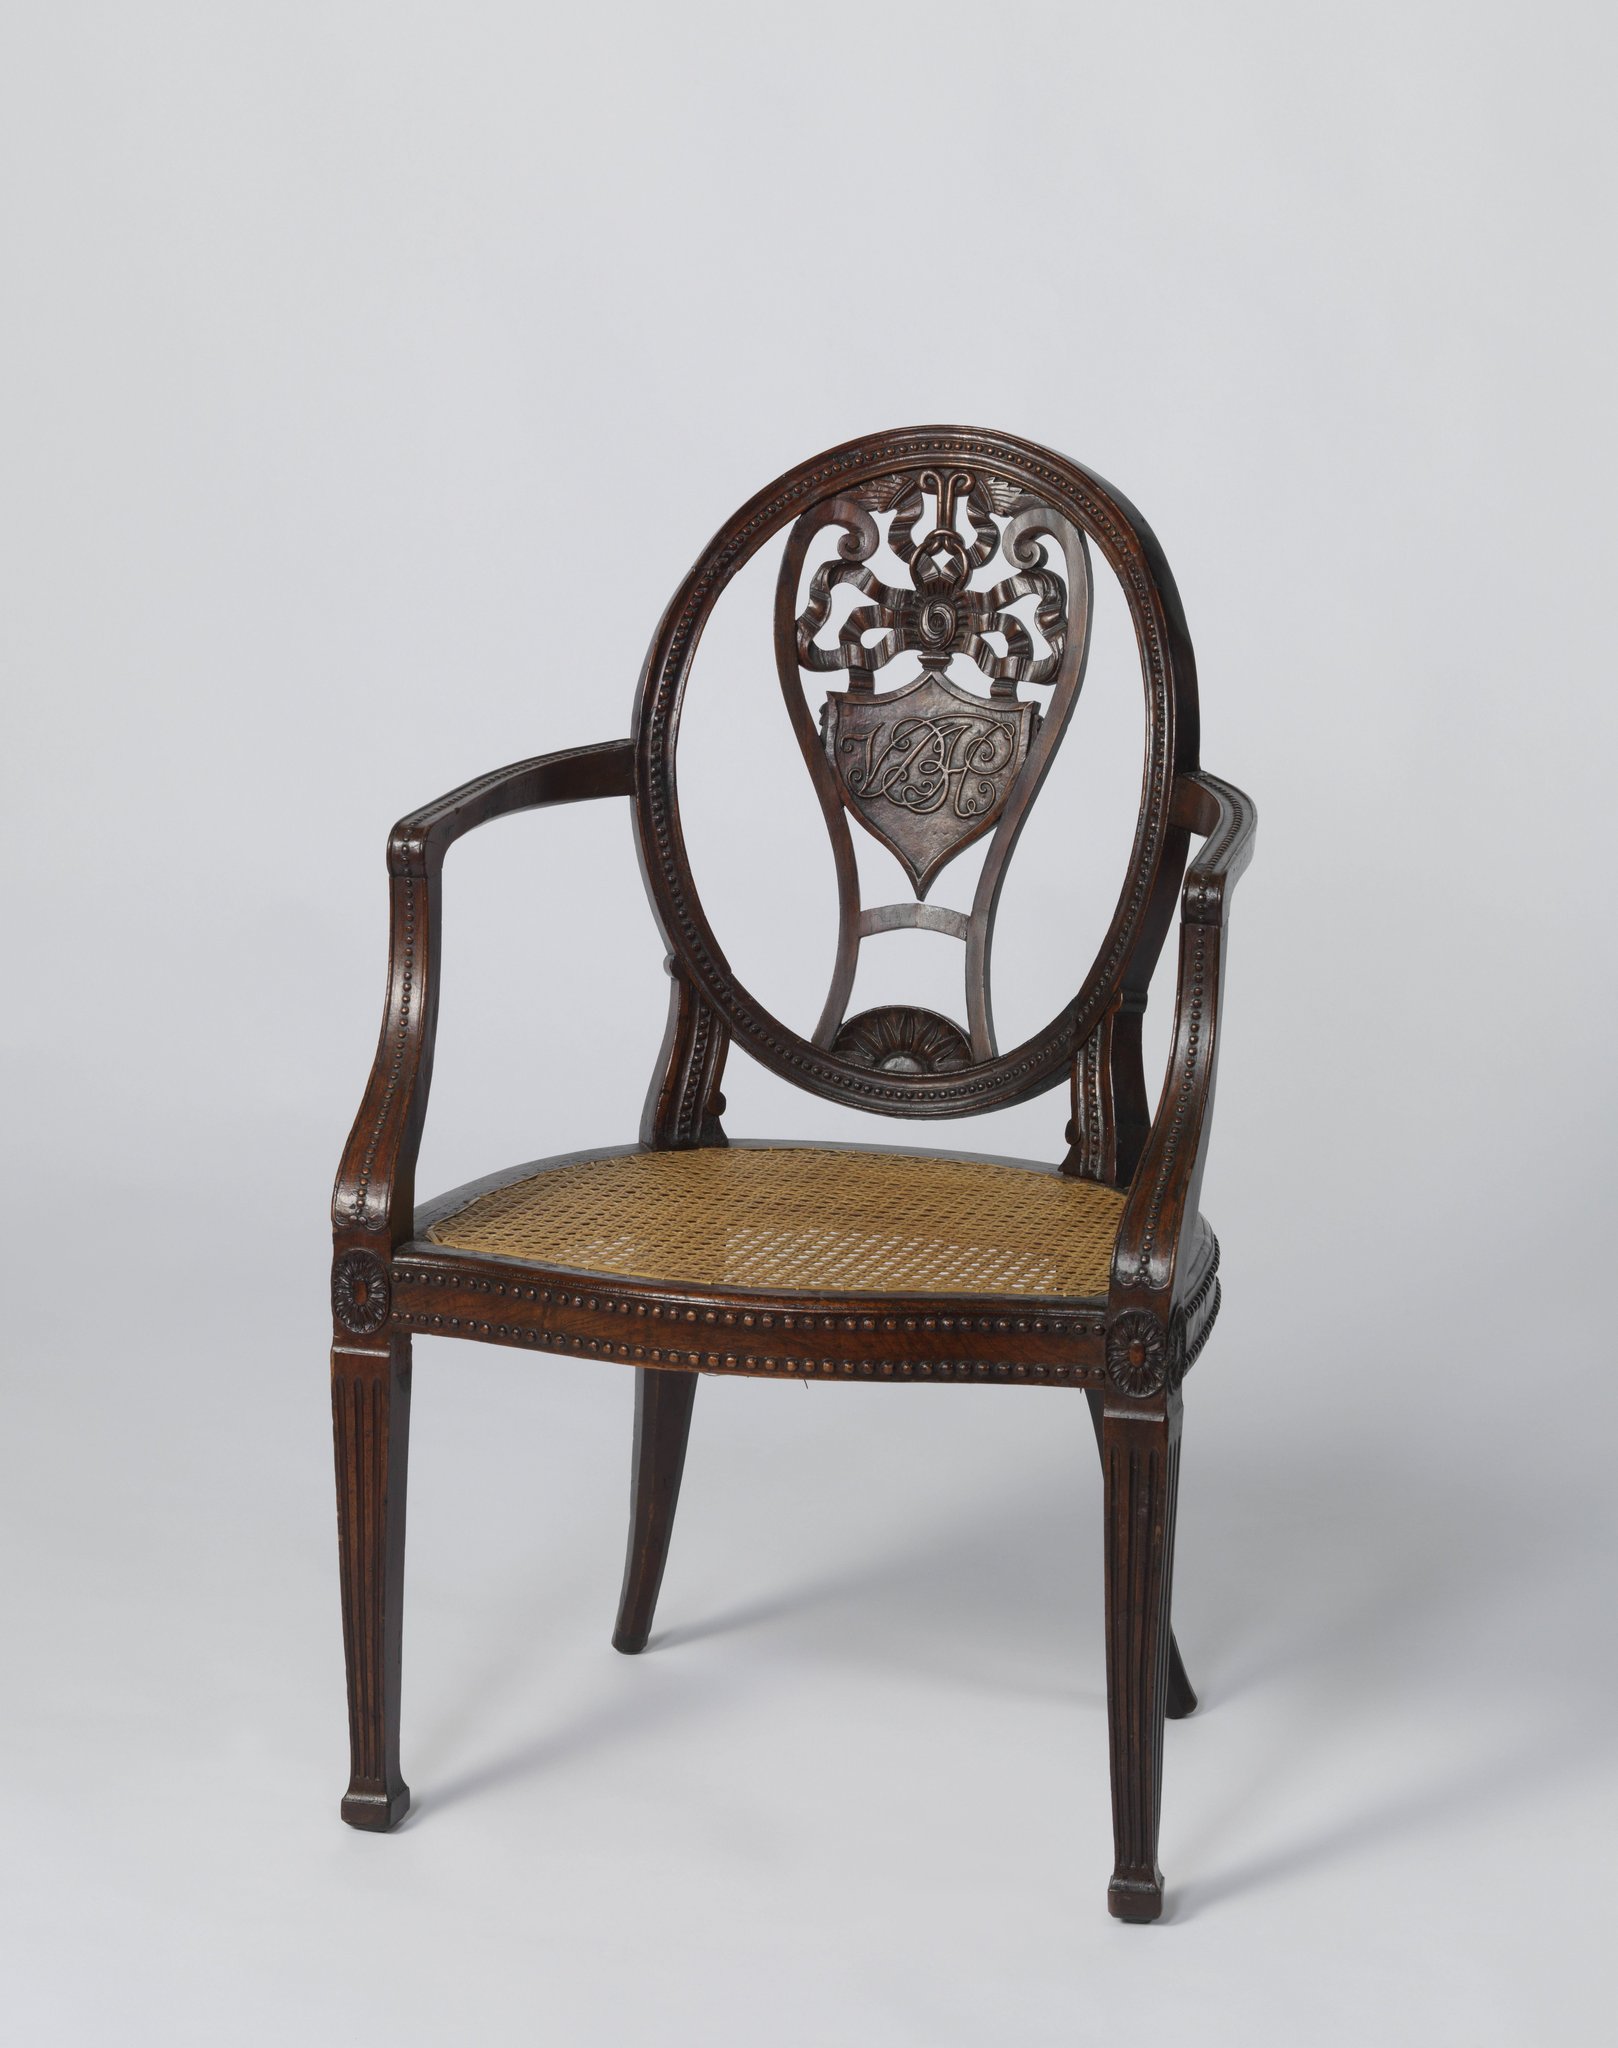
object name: chair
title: Armchair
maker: Anonymous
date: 1795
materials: rattan, wood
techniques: colour, lacquer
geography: guangdong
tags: koopman, andreas everardus van braam houckgeest, kanton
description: This armchair was made in China after a model that was popular in England at the end of the 18th century. The Chinese furniture-maker probably relied on a print as his source of inspiration. It was commissioned by Van Braam Houckgeest, whose initials are on the back of the chair.